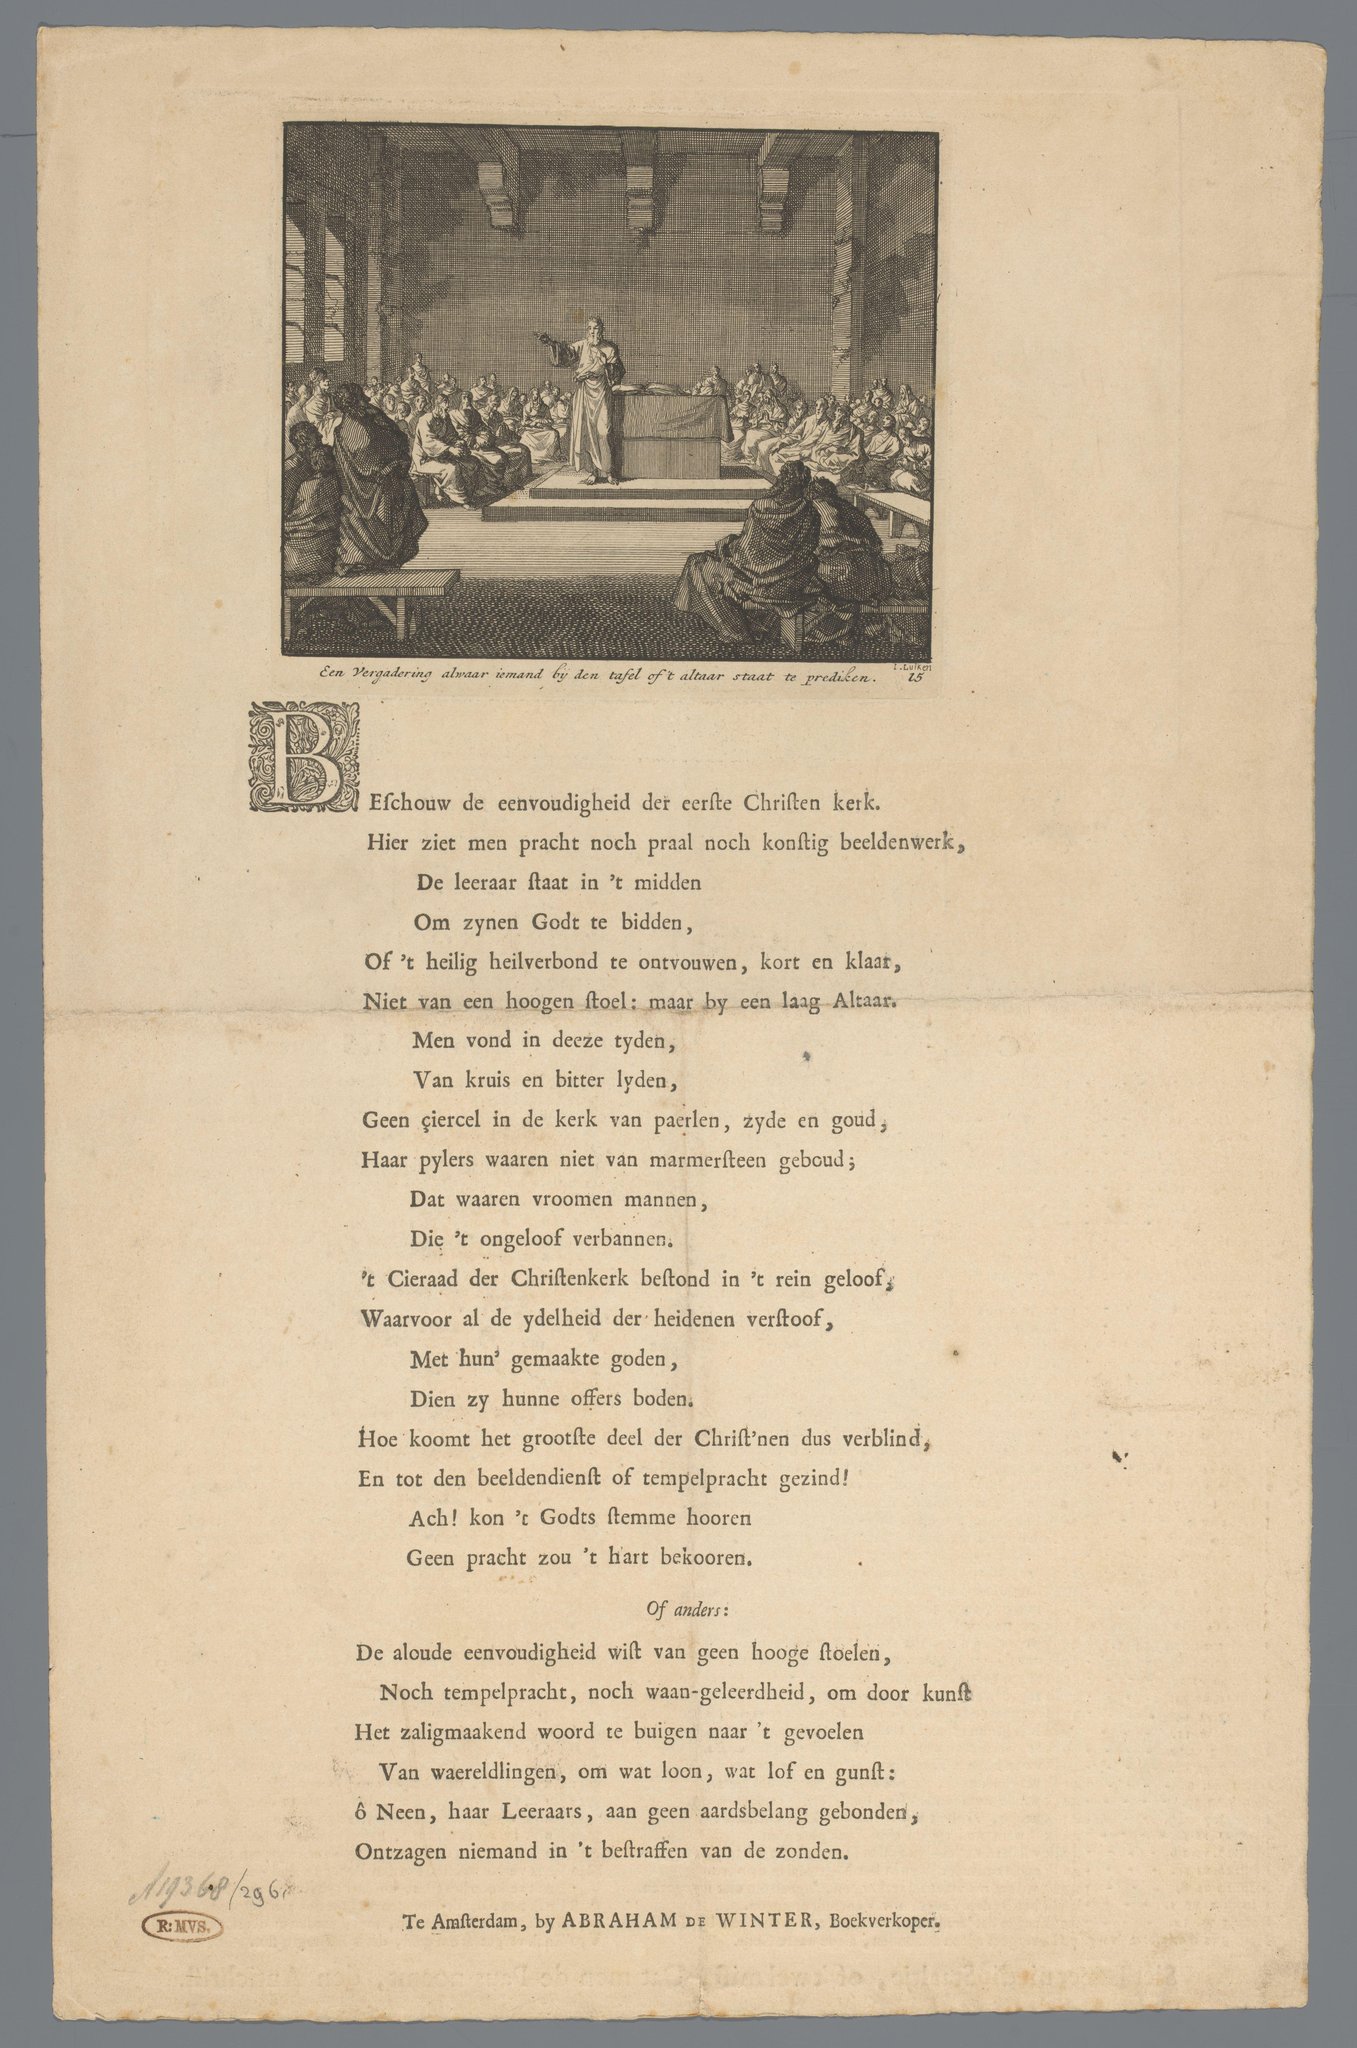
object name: print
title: Een vergadering alwaar iemand bij de tafel of 't altaar staat te prediken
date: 1659-1712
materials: paper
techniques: etching